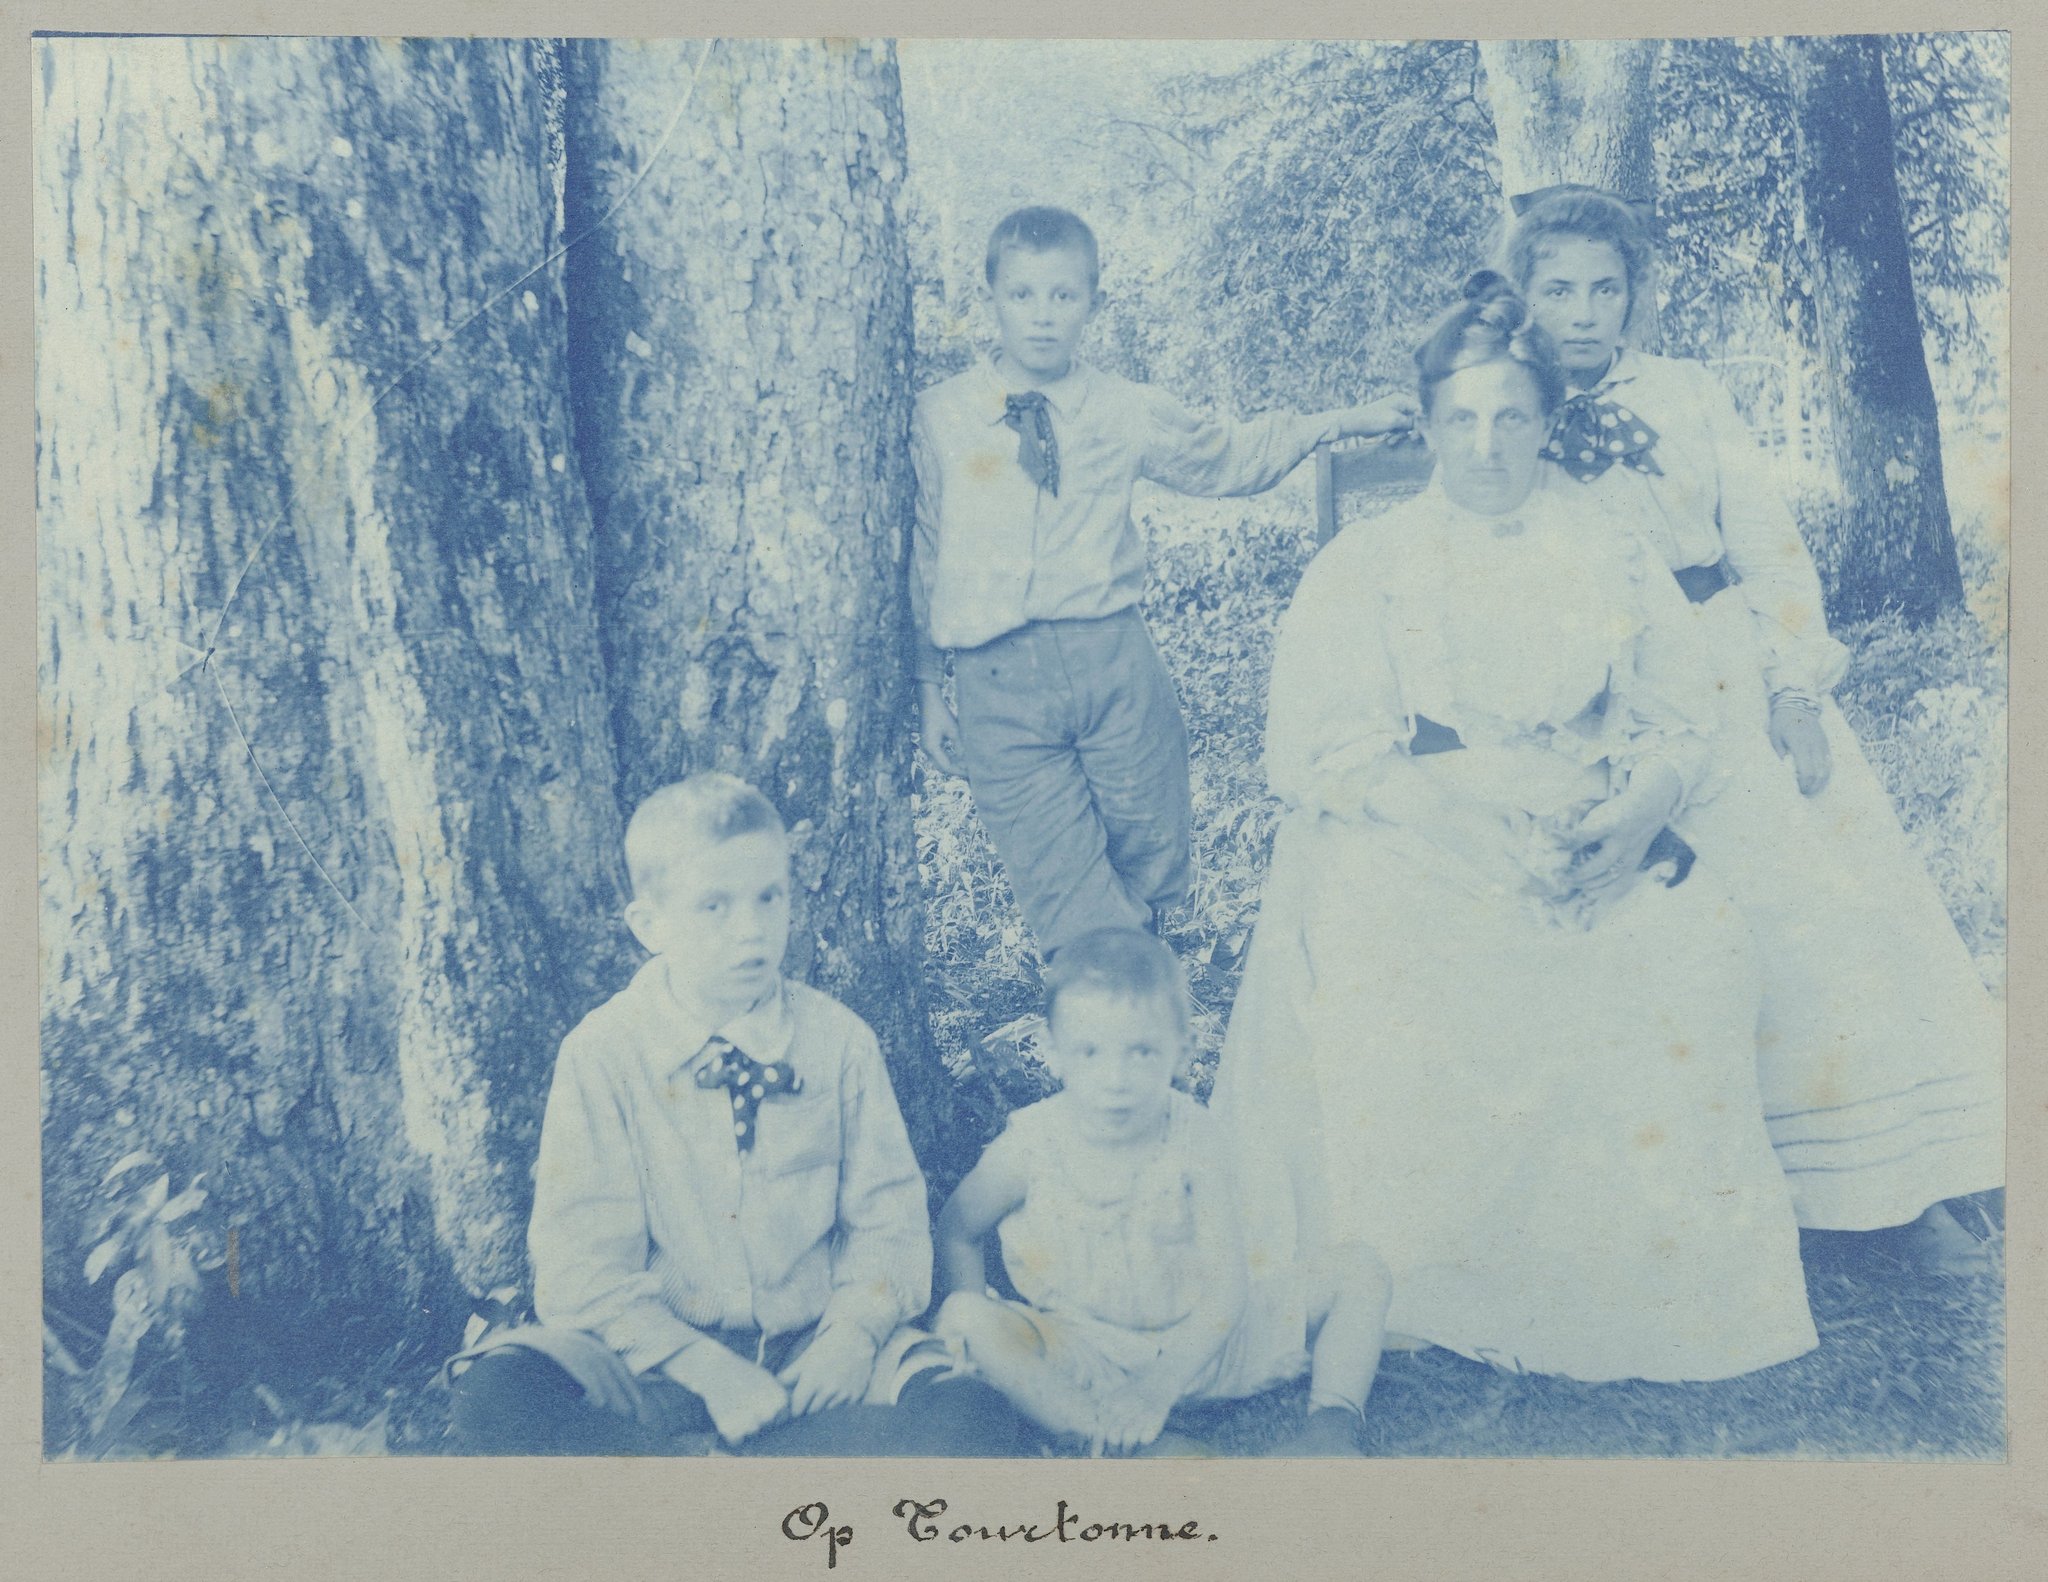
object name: photograph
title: Op Tourtonne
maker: hendrik doijer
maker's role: engineer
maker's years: 1863-1925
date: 1903-1910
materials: photographic support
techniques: cyanotype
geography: suriname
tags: suriname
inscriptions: inscription: ‘E14 / Op Tourtonne.’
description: Familiefoto van moeder met vier kinderen (o.a. Pim, Anton en To), in de tuin onder een boom op Plantage Tourtonne. Onderdeel van het fotoalbum Souvenir de Voyage (deel 4), over het leven van de familie Doijer in en rond de plantage Ma Retraite in Suriname in de jaren 1903-1910.